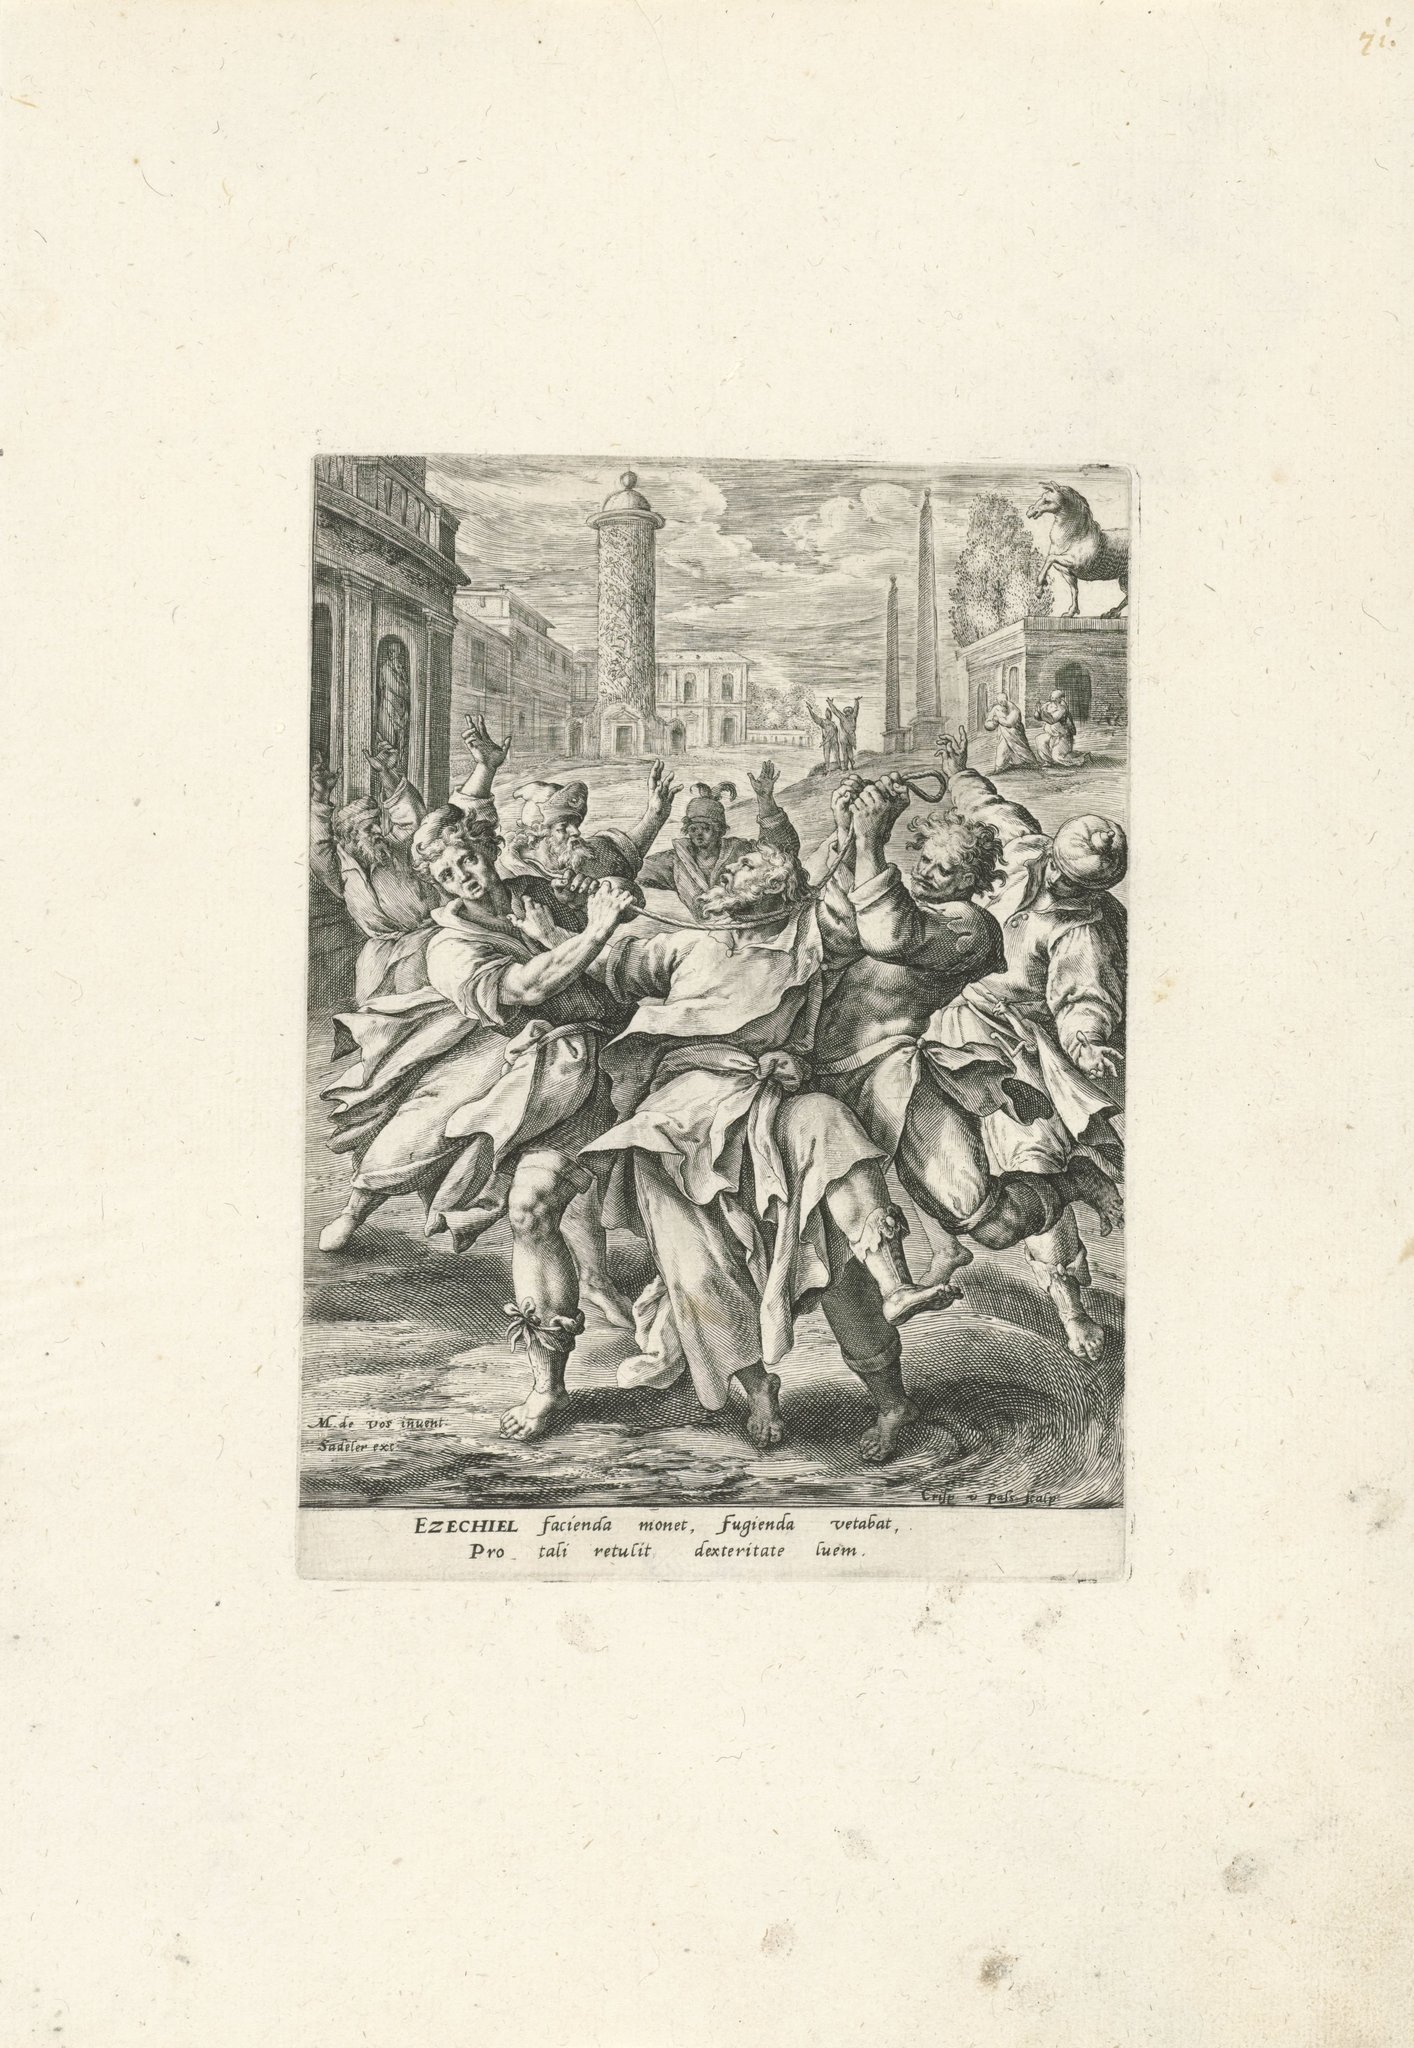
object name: print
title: Triumphus Martyrum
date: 1591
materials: paper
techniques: engraving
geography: antwerp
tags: the book of ezekiel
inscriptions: collector's mark: Lugt 2228, inscription: ‘71.’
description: Prent ook gebruikt in: Triumphus martyrum. Antwerpen: Aegidius en Johann (I) Sadeler, 1591. Overgenomen uit inventarisboek: RP-P-1966-37 tot en met RP-P-1966-180 alle afkomstig uit een 19e(?) eeuwse plakband. Op de rug het nr. 15, op de voorpagina: John Bridges 1836.